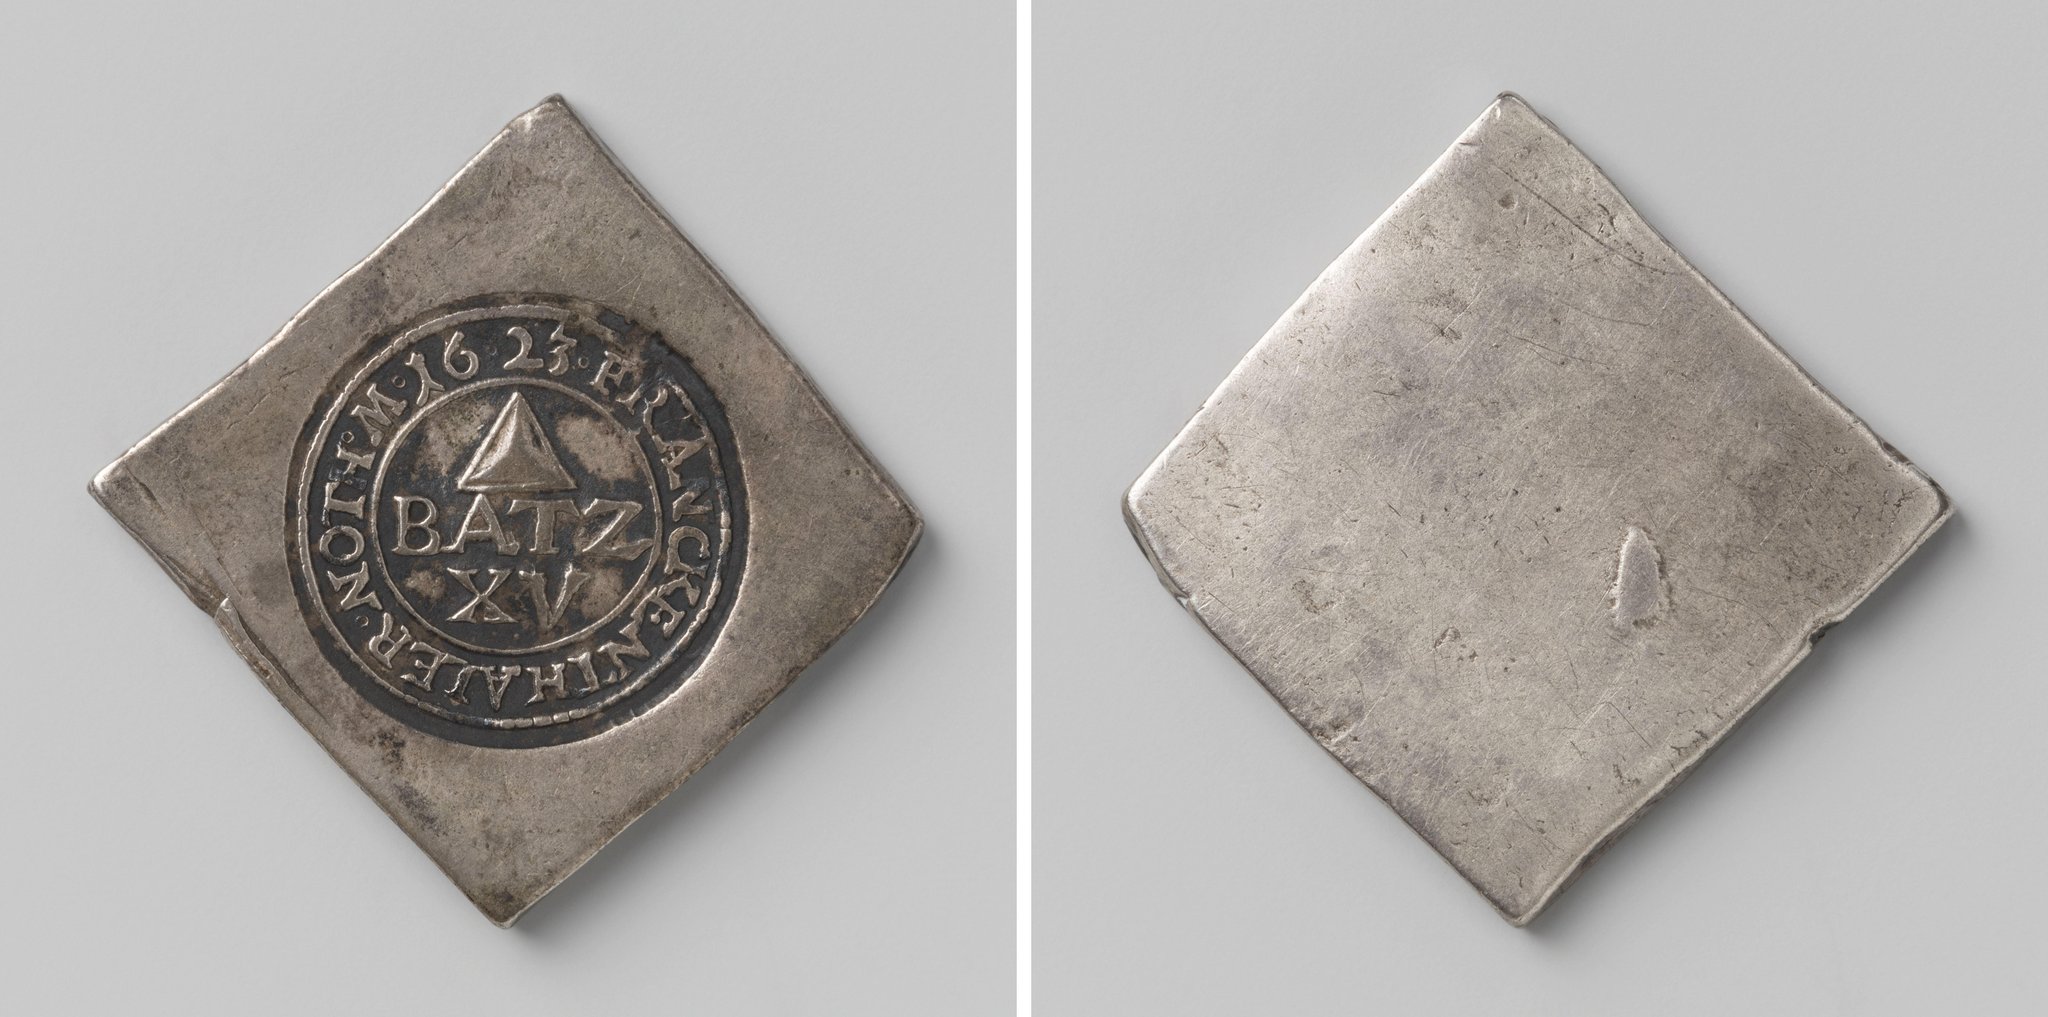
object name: coin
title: vijftien batz, noodmunt uit Frankenthal, geslagen tijdens het beleg door Verdugo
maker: Anonymous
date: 1623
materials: silver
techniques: striking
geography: frankenthal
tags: bad kreuznach, generaal, wilhelm von verdugo (graaf), frankenthal, beleg van frankenthal (1623)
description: eenzijdige, ruitvormige noodmunt. Voorzijde: een stempel; hoeksteen boven waardeaanduiding binnen omschrift. Keerzijde: blanco